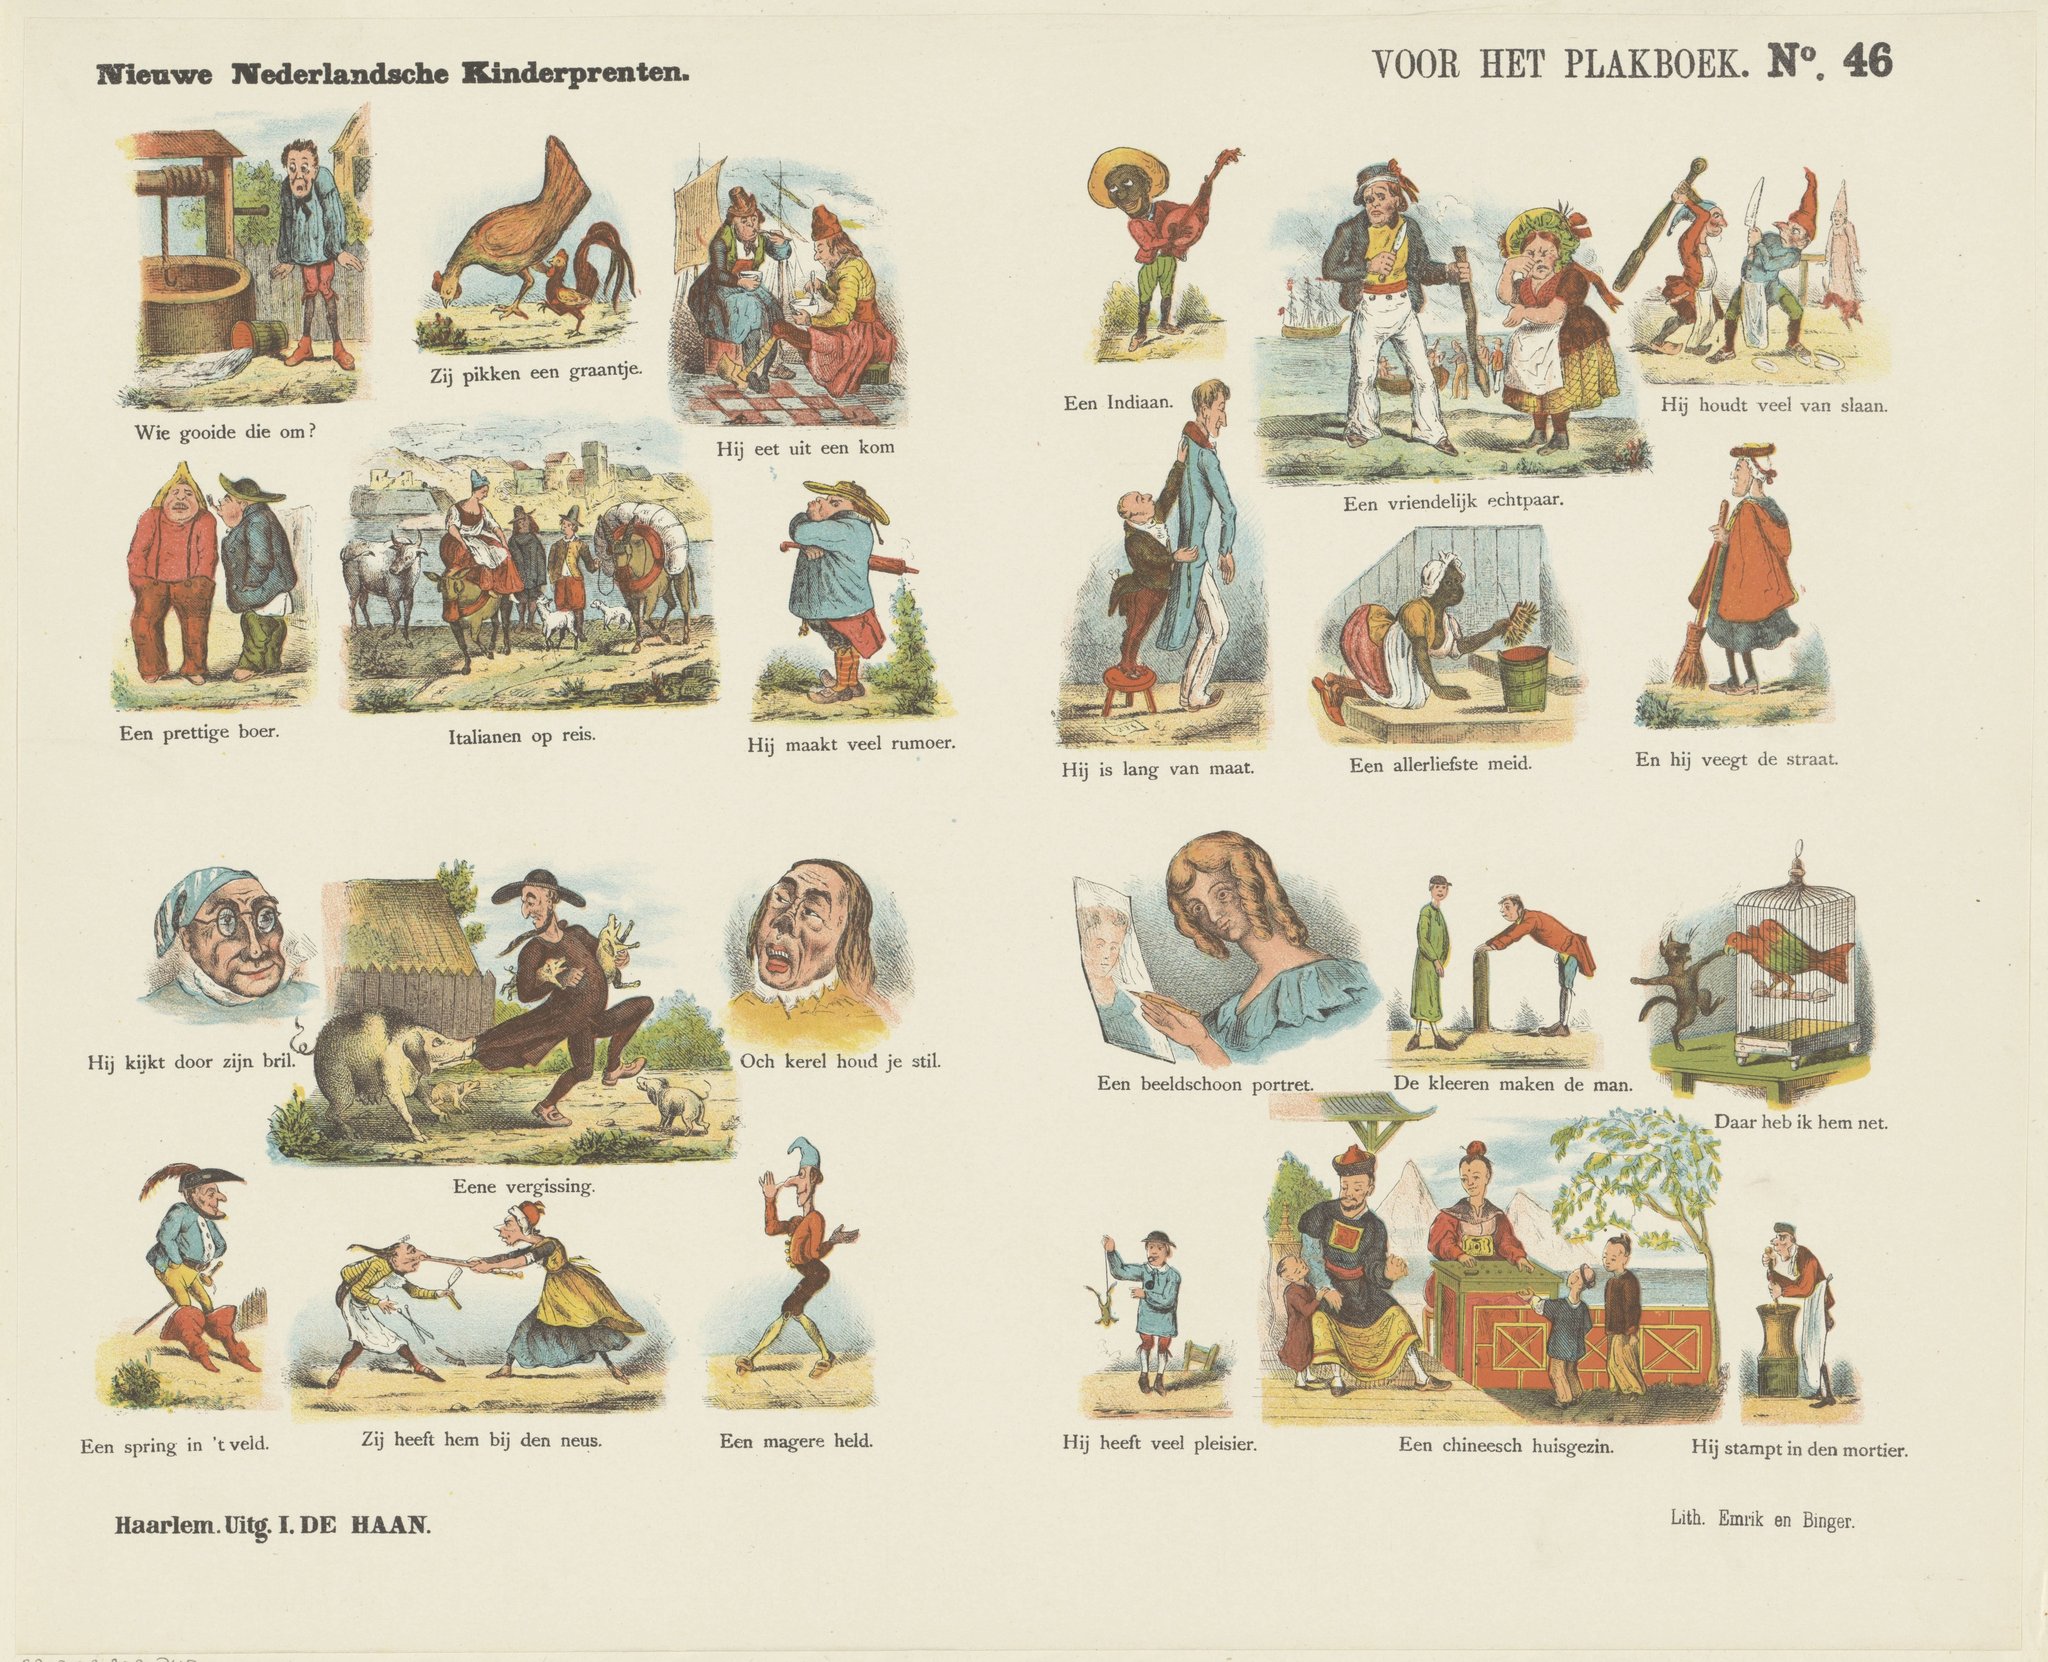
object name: popular print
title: Voor het plakboek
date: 1875-1903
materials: paper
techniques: lithograph, letterpress printing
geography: haarlem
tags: caricatures (human types), characters (human types)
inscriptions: collector's mark: Lugt 2760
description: Blad met 24 voorstellingen van verschillende aard, waaronder voorstellingen van karikaturale koppen en figuren. Genummerd rechtsboven: No. 46.